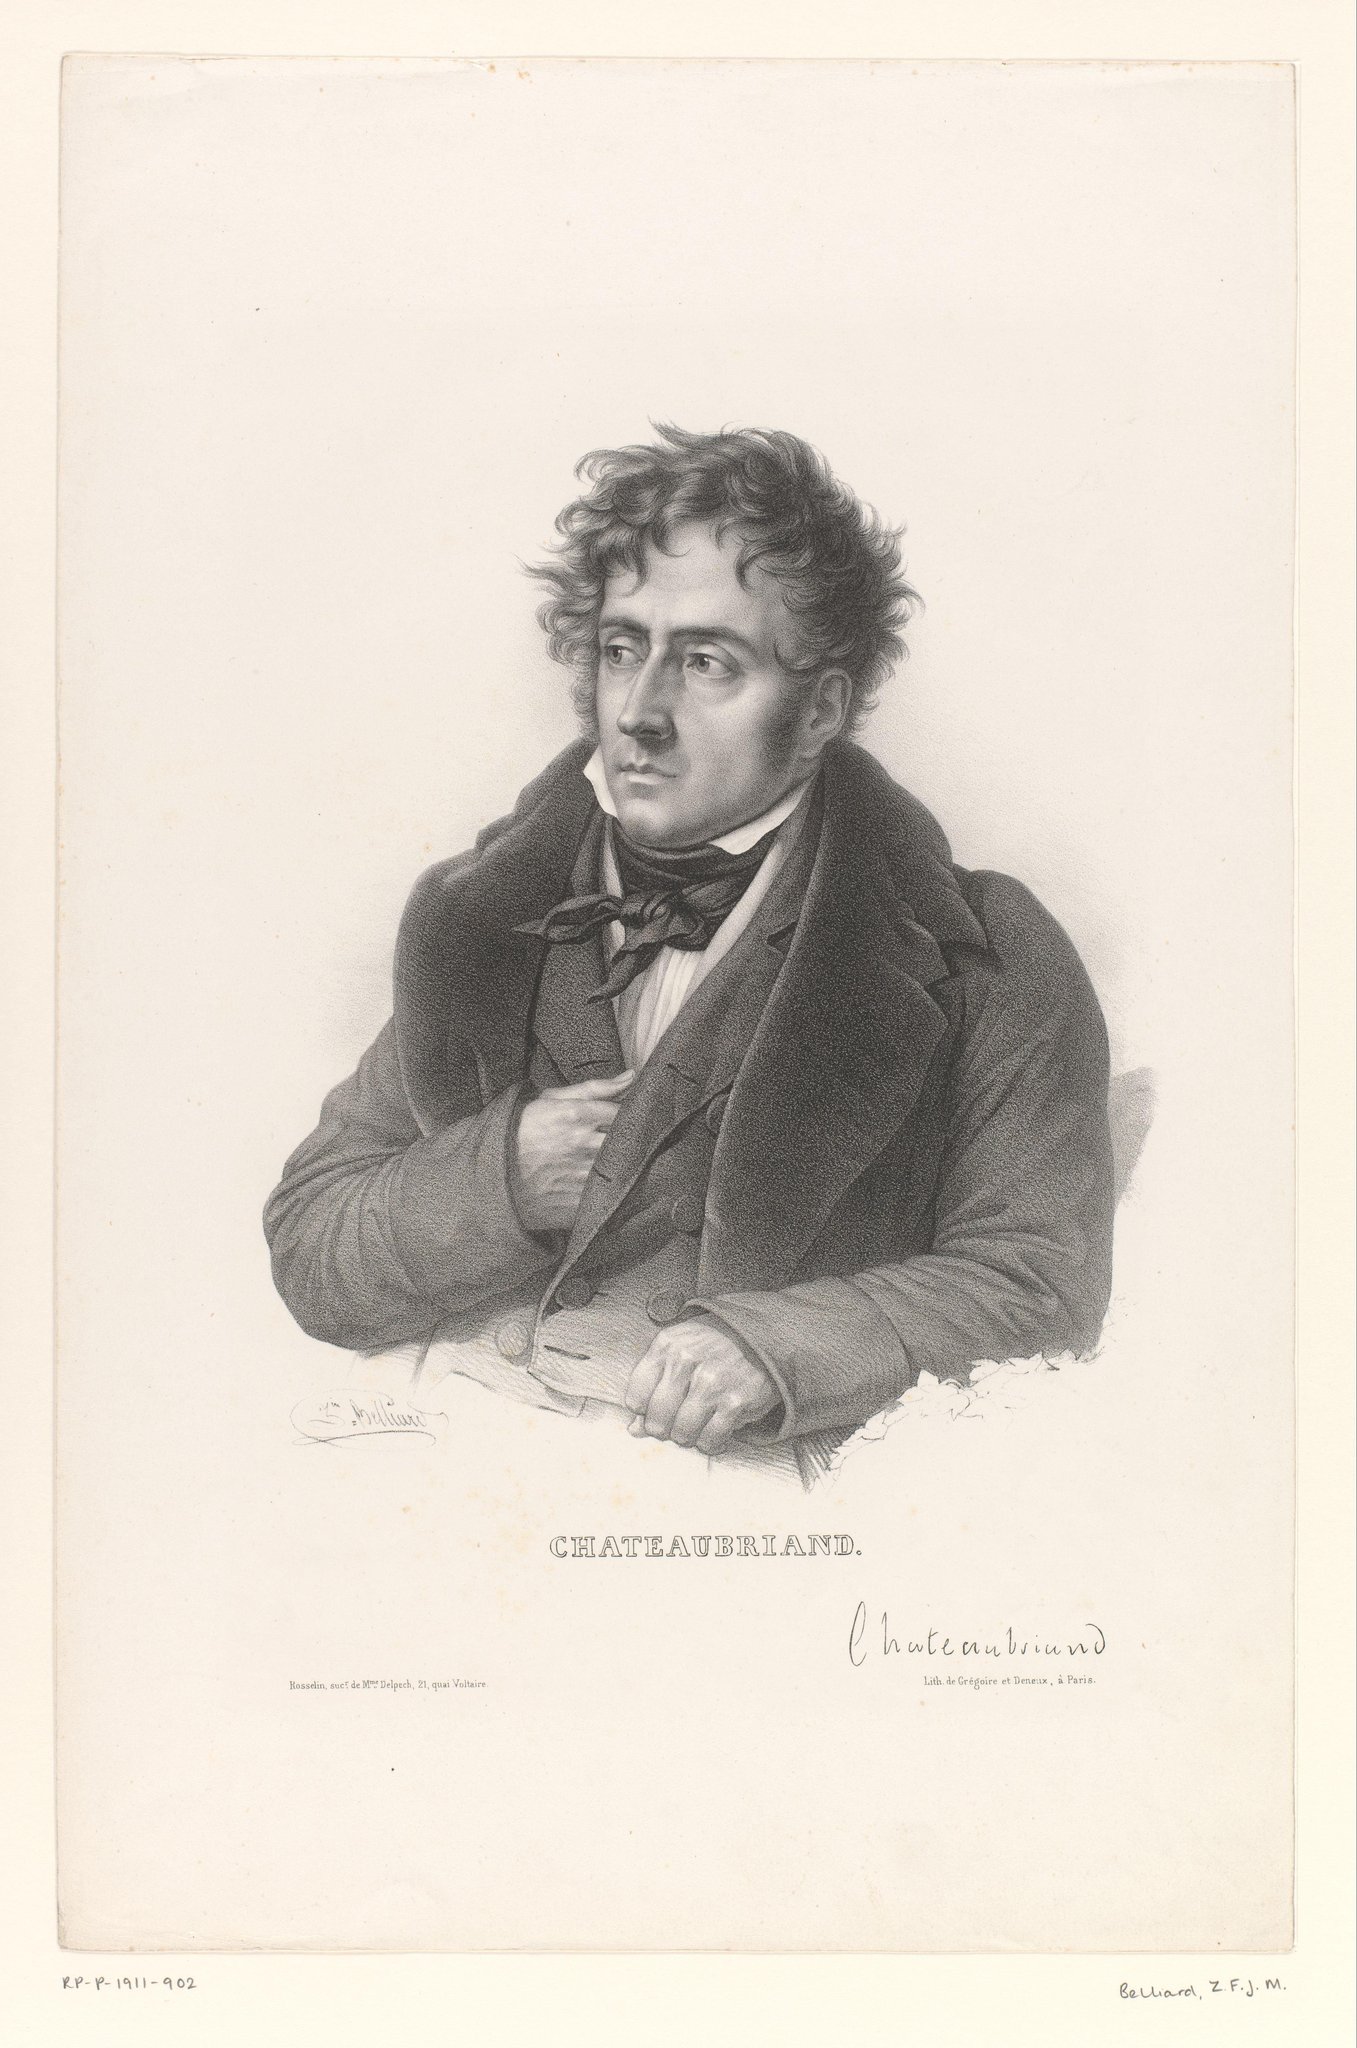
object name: print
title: Portretten van 1789 tot 1829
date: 1831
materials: paper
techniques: lithograph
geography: paris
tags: paris, politician, françois-rené de chateaubriand, historical persons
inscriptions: collector's mark: Lugt 2228a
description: Prent gepubliceerd in: Iconographie des contemporaines ou portraits des personnes depuis 1789, jusqu'en 1829, Delpech, Parijs 1832.